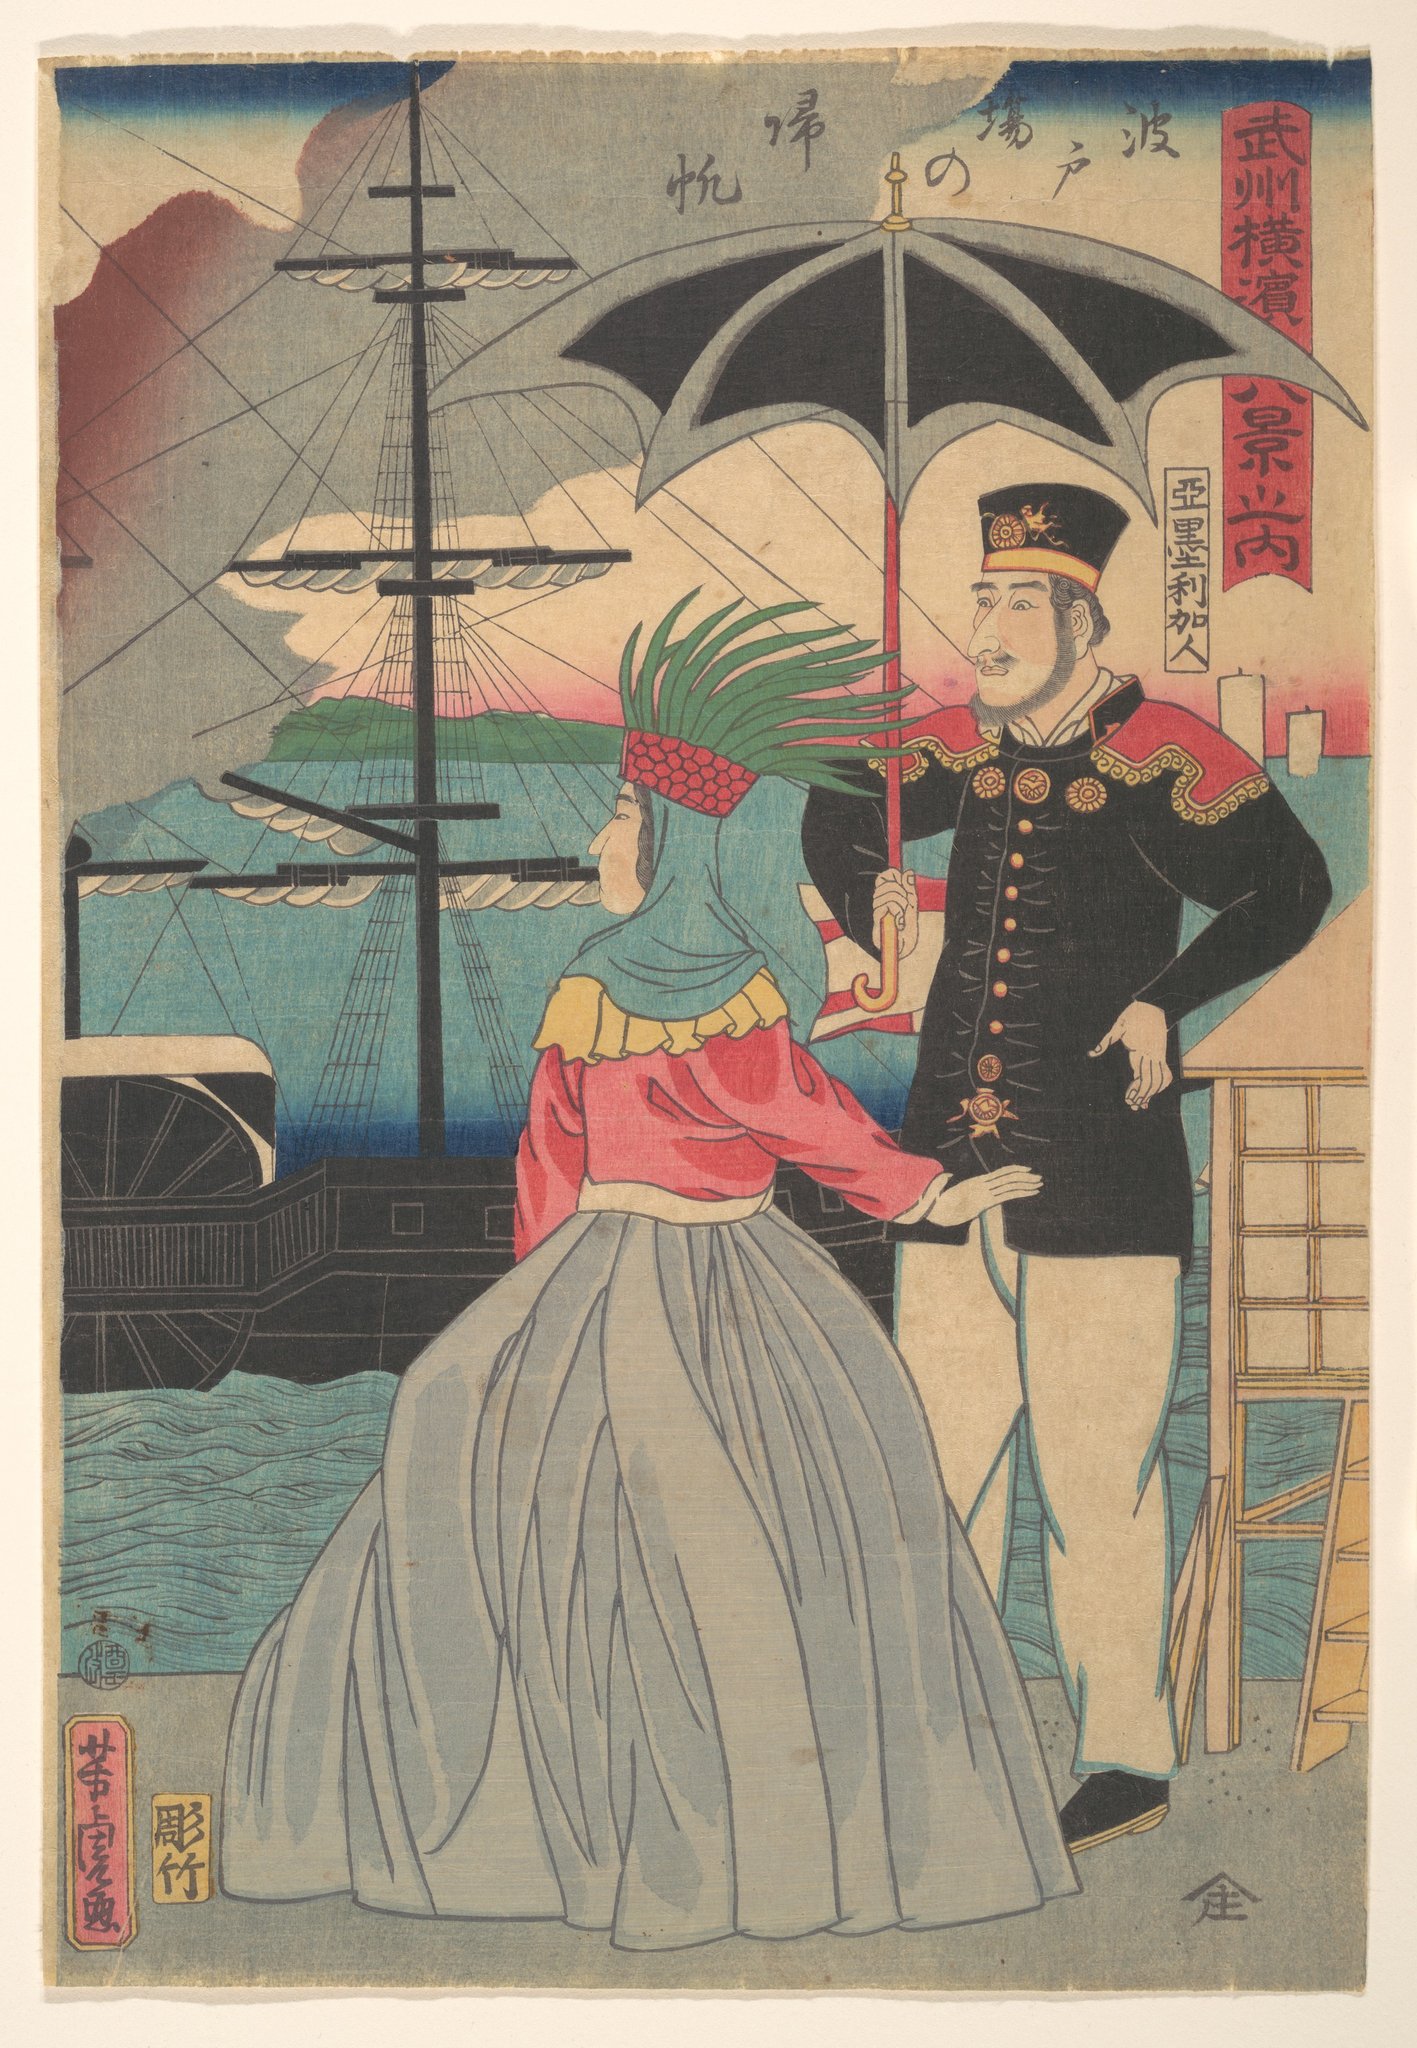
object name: print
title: Returning Sails at the Wharves [American couple]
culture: japanese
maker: utagawa yoshitora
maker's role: artist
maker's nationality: japanese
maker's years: 1845-1880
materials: ink, paper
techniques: woodblock print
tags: men,women,ships,umbrellas